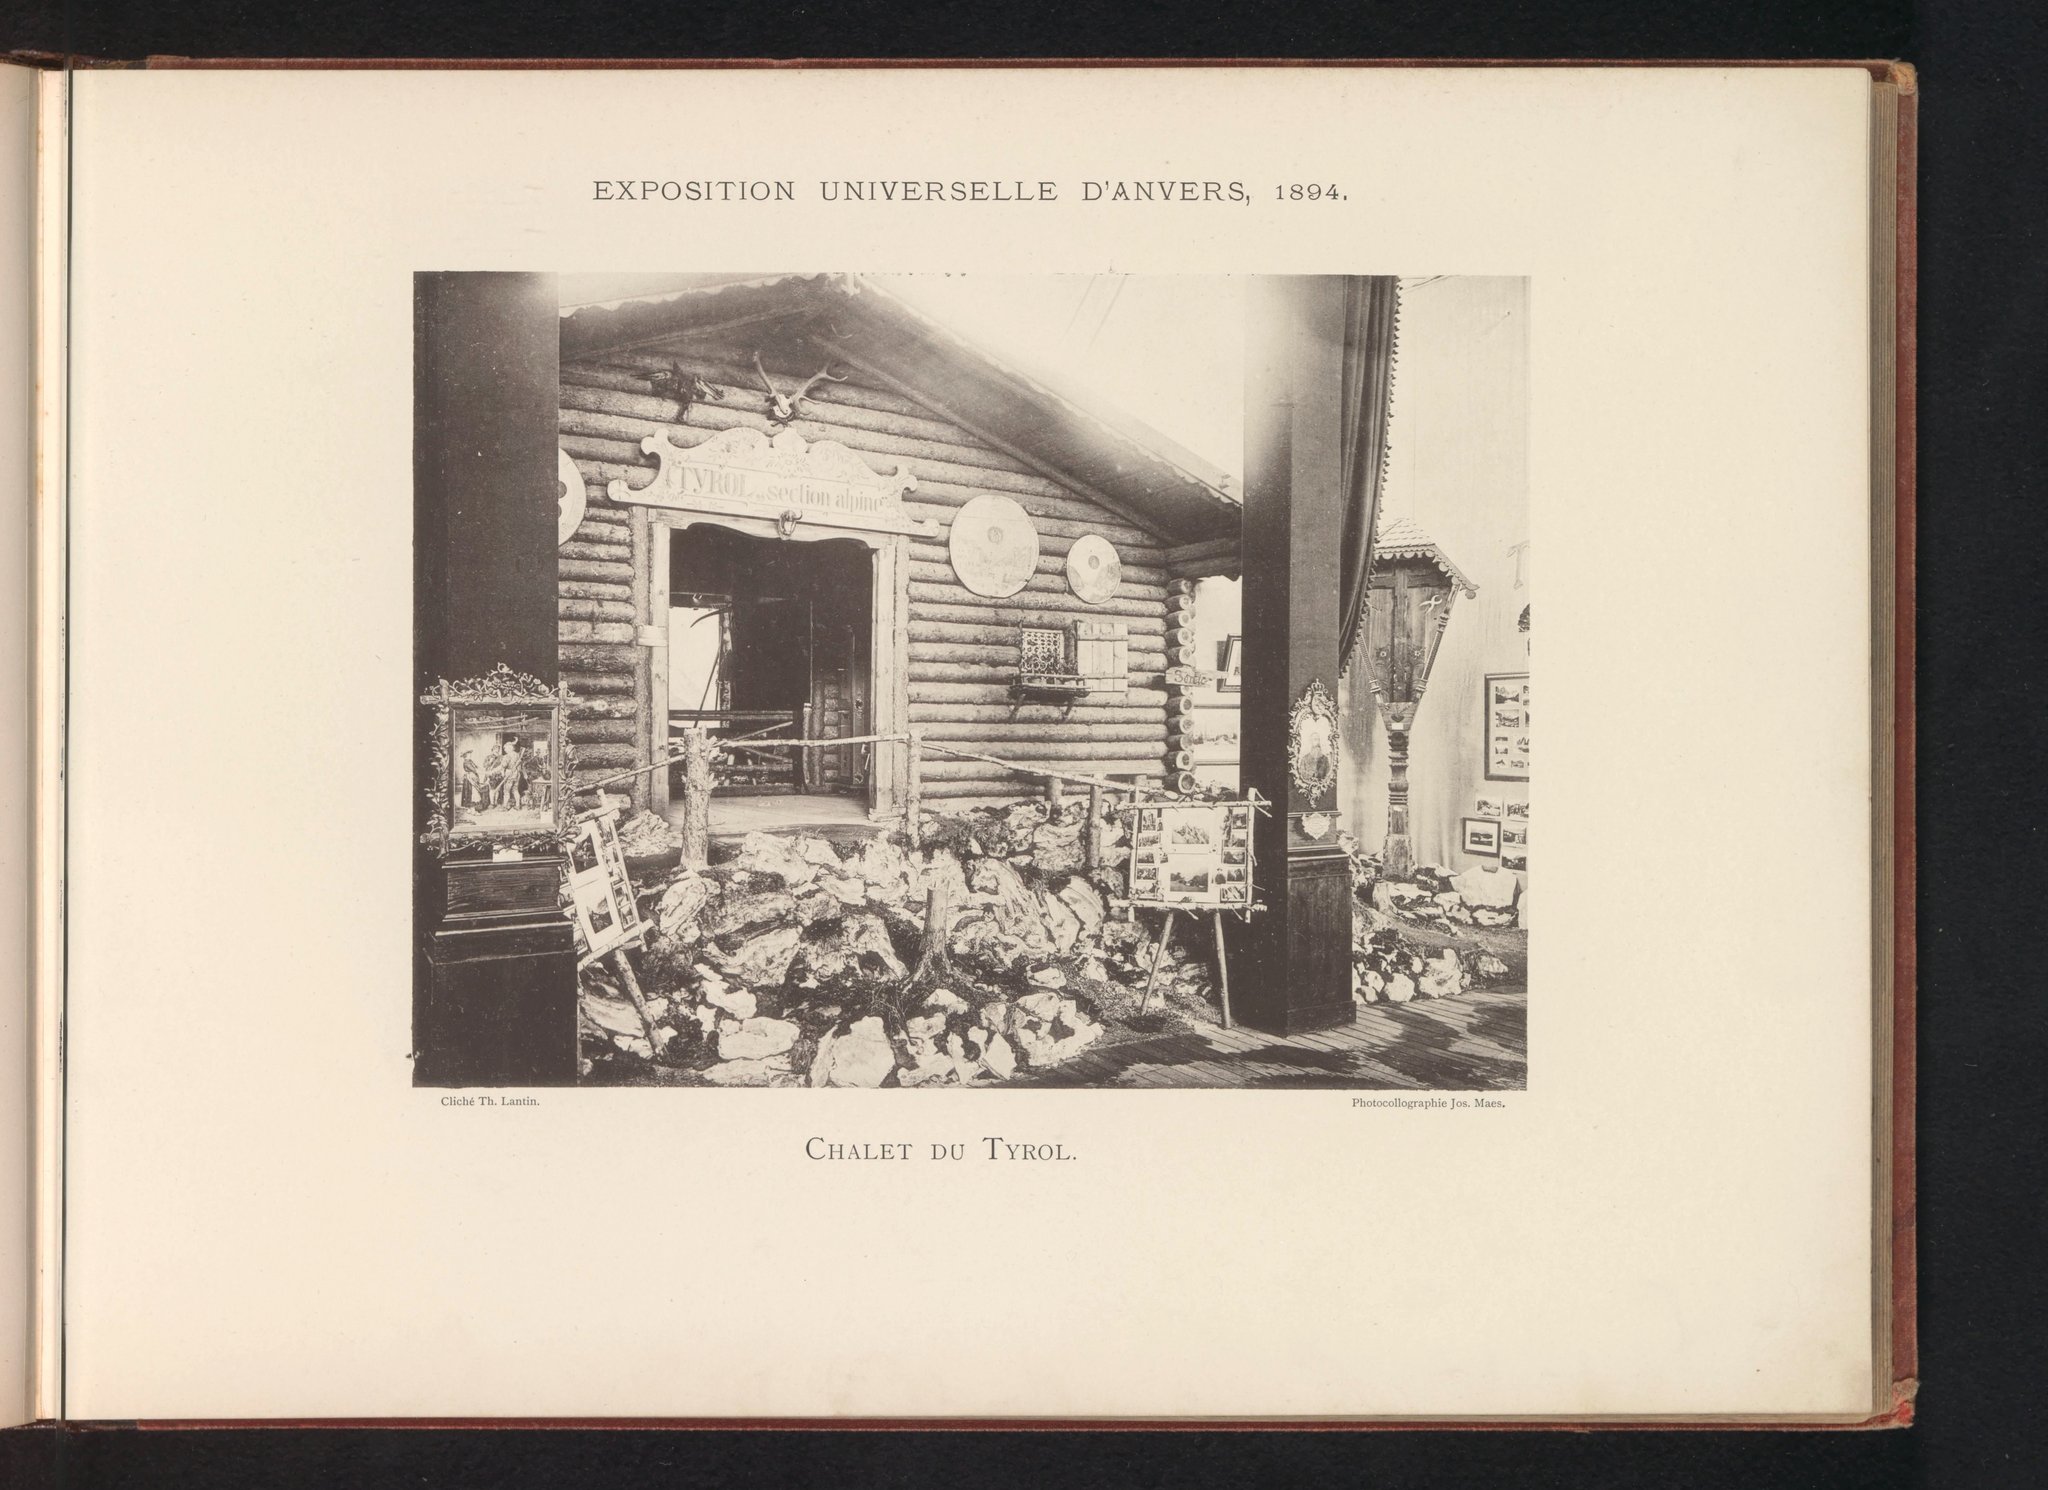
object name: page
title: Tiroler chalet in de wereldtentoonstelling te Antwerpen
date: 1894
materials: paper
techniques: photograph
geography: antwerp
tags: log-cabin, world fair, world exhibition, collection, exhibition, show